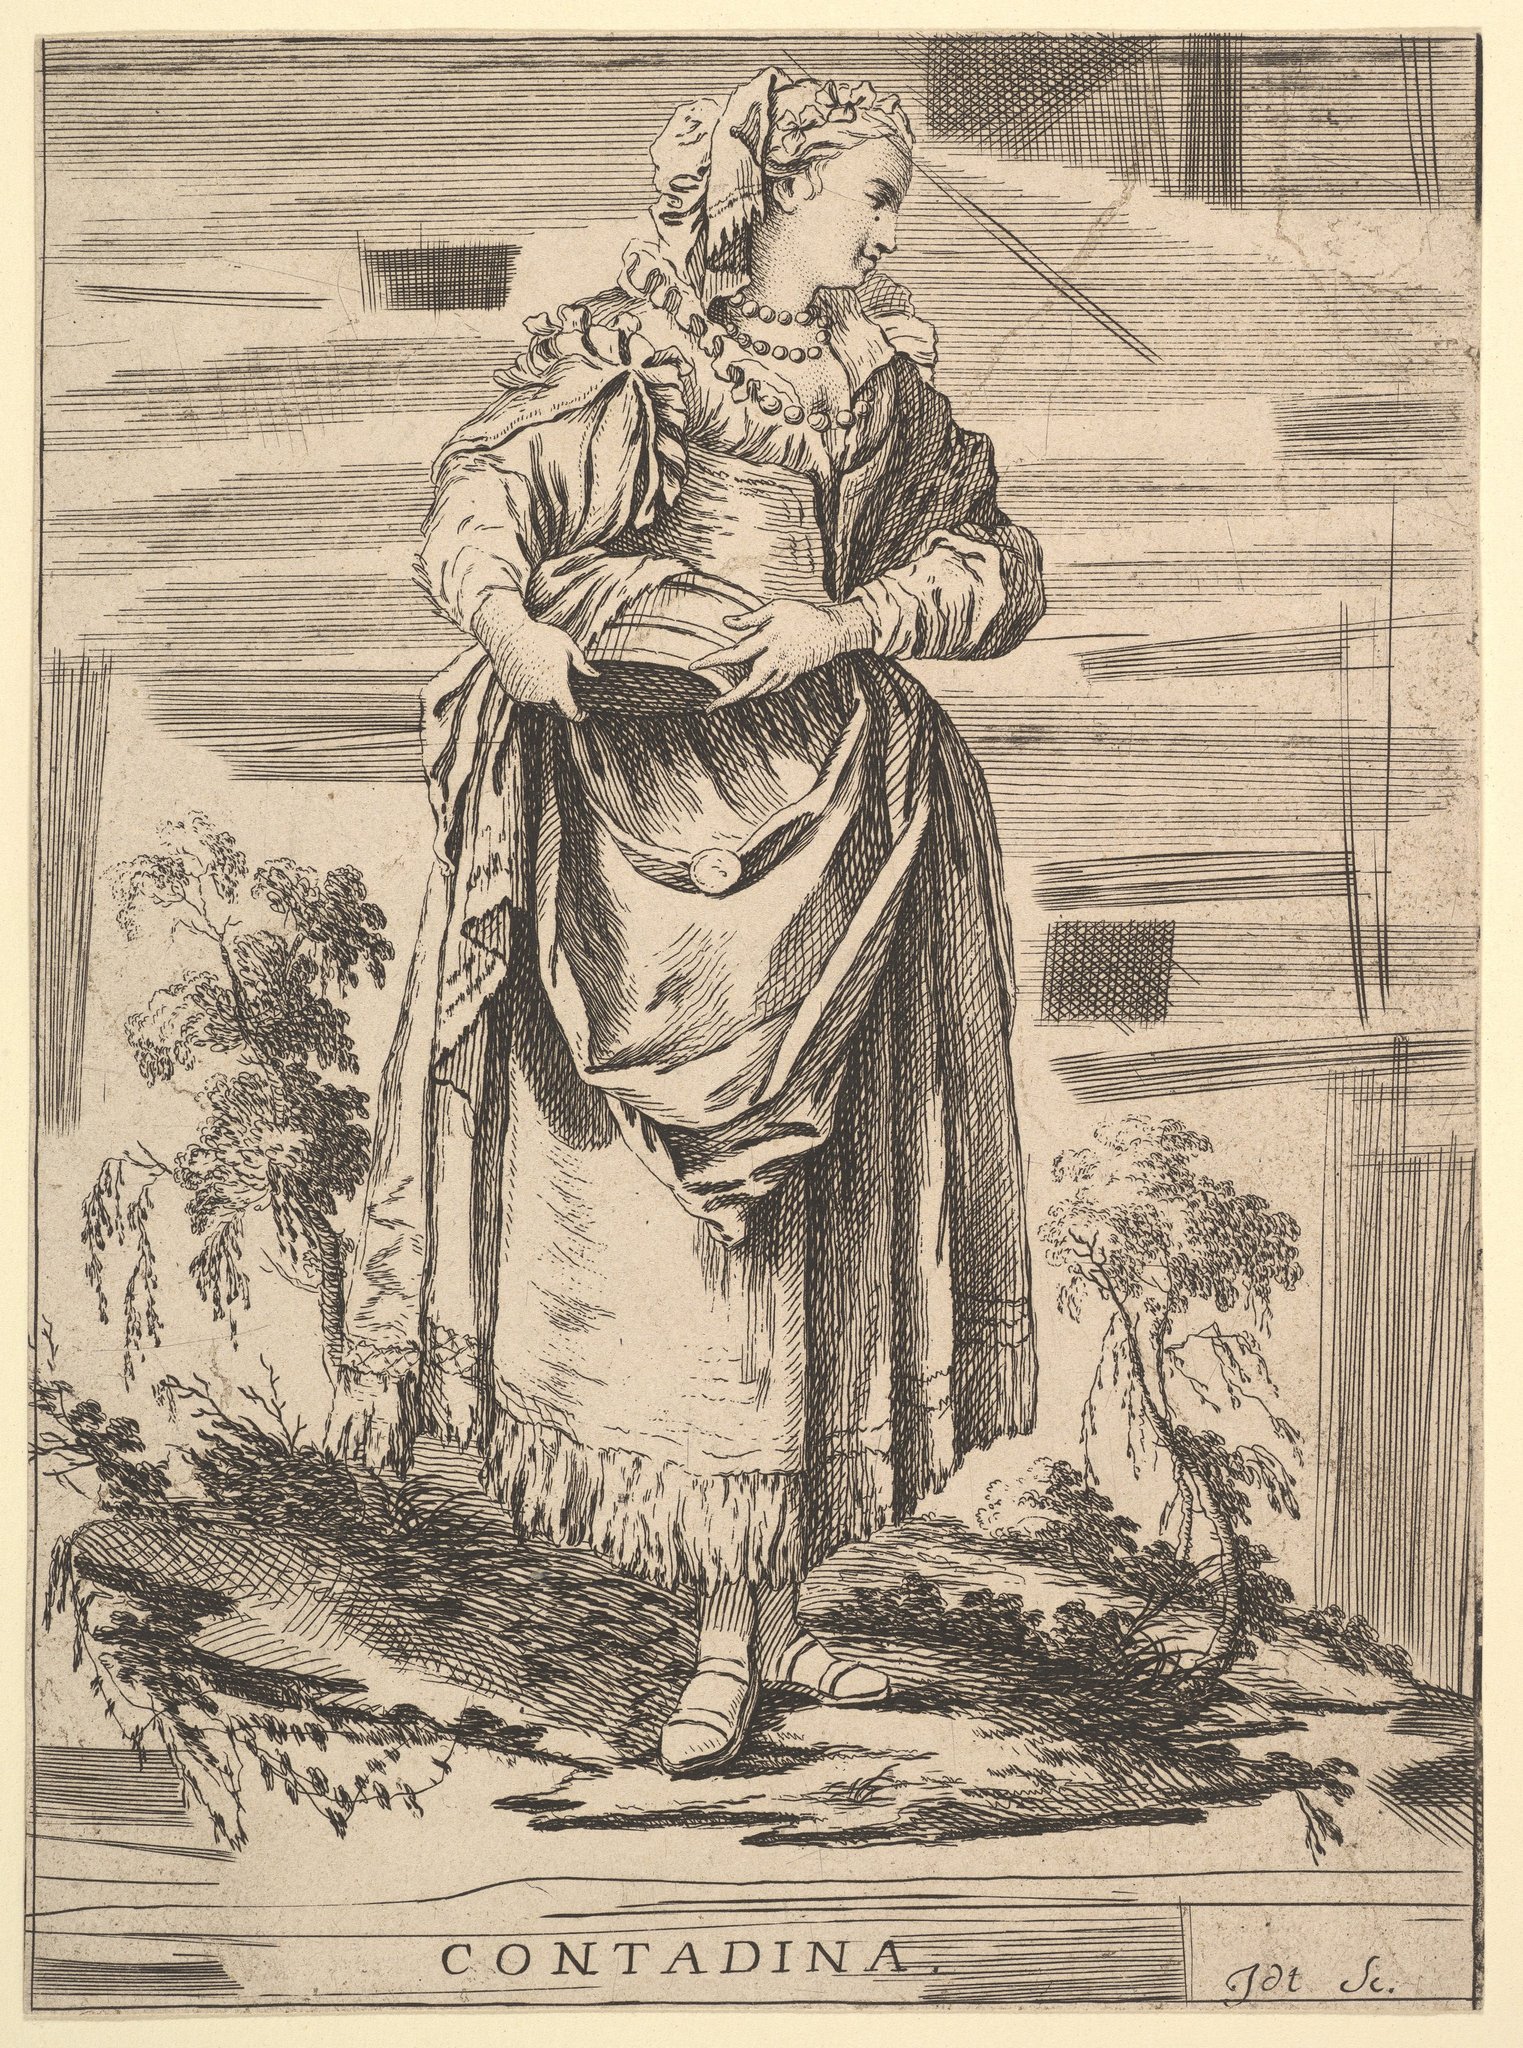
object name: print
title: Reverse copy of Contadina, Recueil de diverses fig.res étrangeres Inventées par F. Boucher P.tre du Roy et Gravées par F. Ravenet (Collection of Various Foreign Figures, Devised by F. Boucher, Painter of the King and Engraved [etched] by F. Ravenet), plate 7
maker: simon francis ravenet, the elder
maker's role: artist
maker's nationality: french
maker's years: 1706-1774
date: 1701-1800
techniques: engraving, etching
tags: women